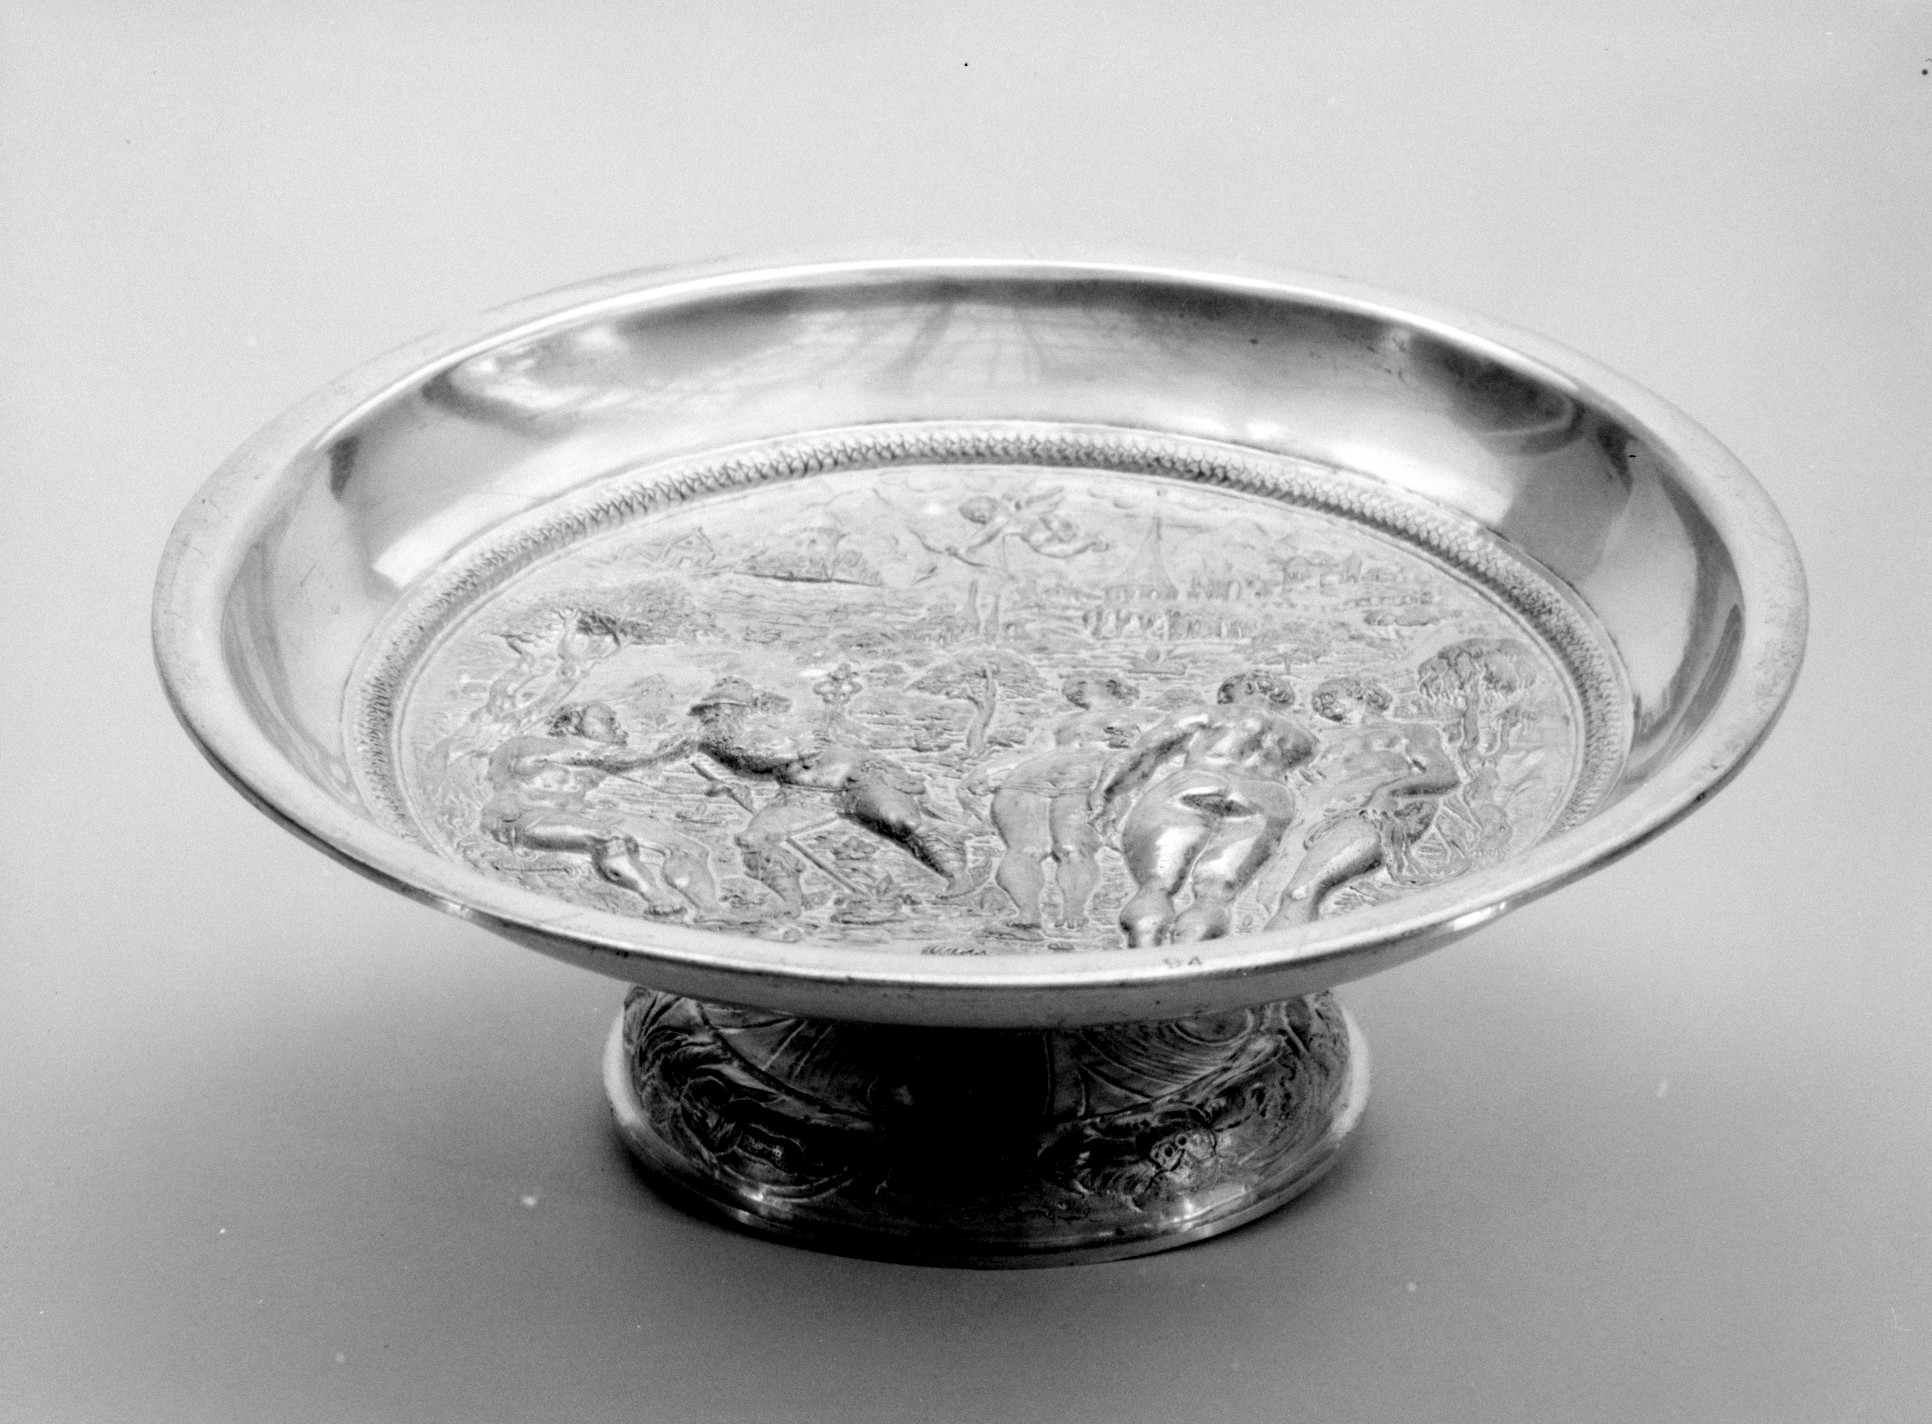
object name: tazza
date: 1801-1900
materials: metal, silver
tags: battles,aphrodite,athena,trees,hera